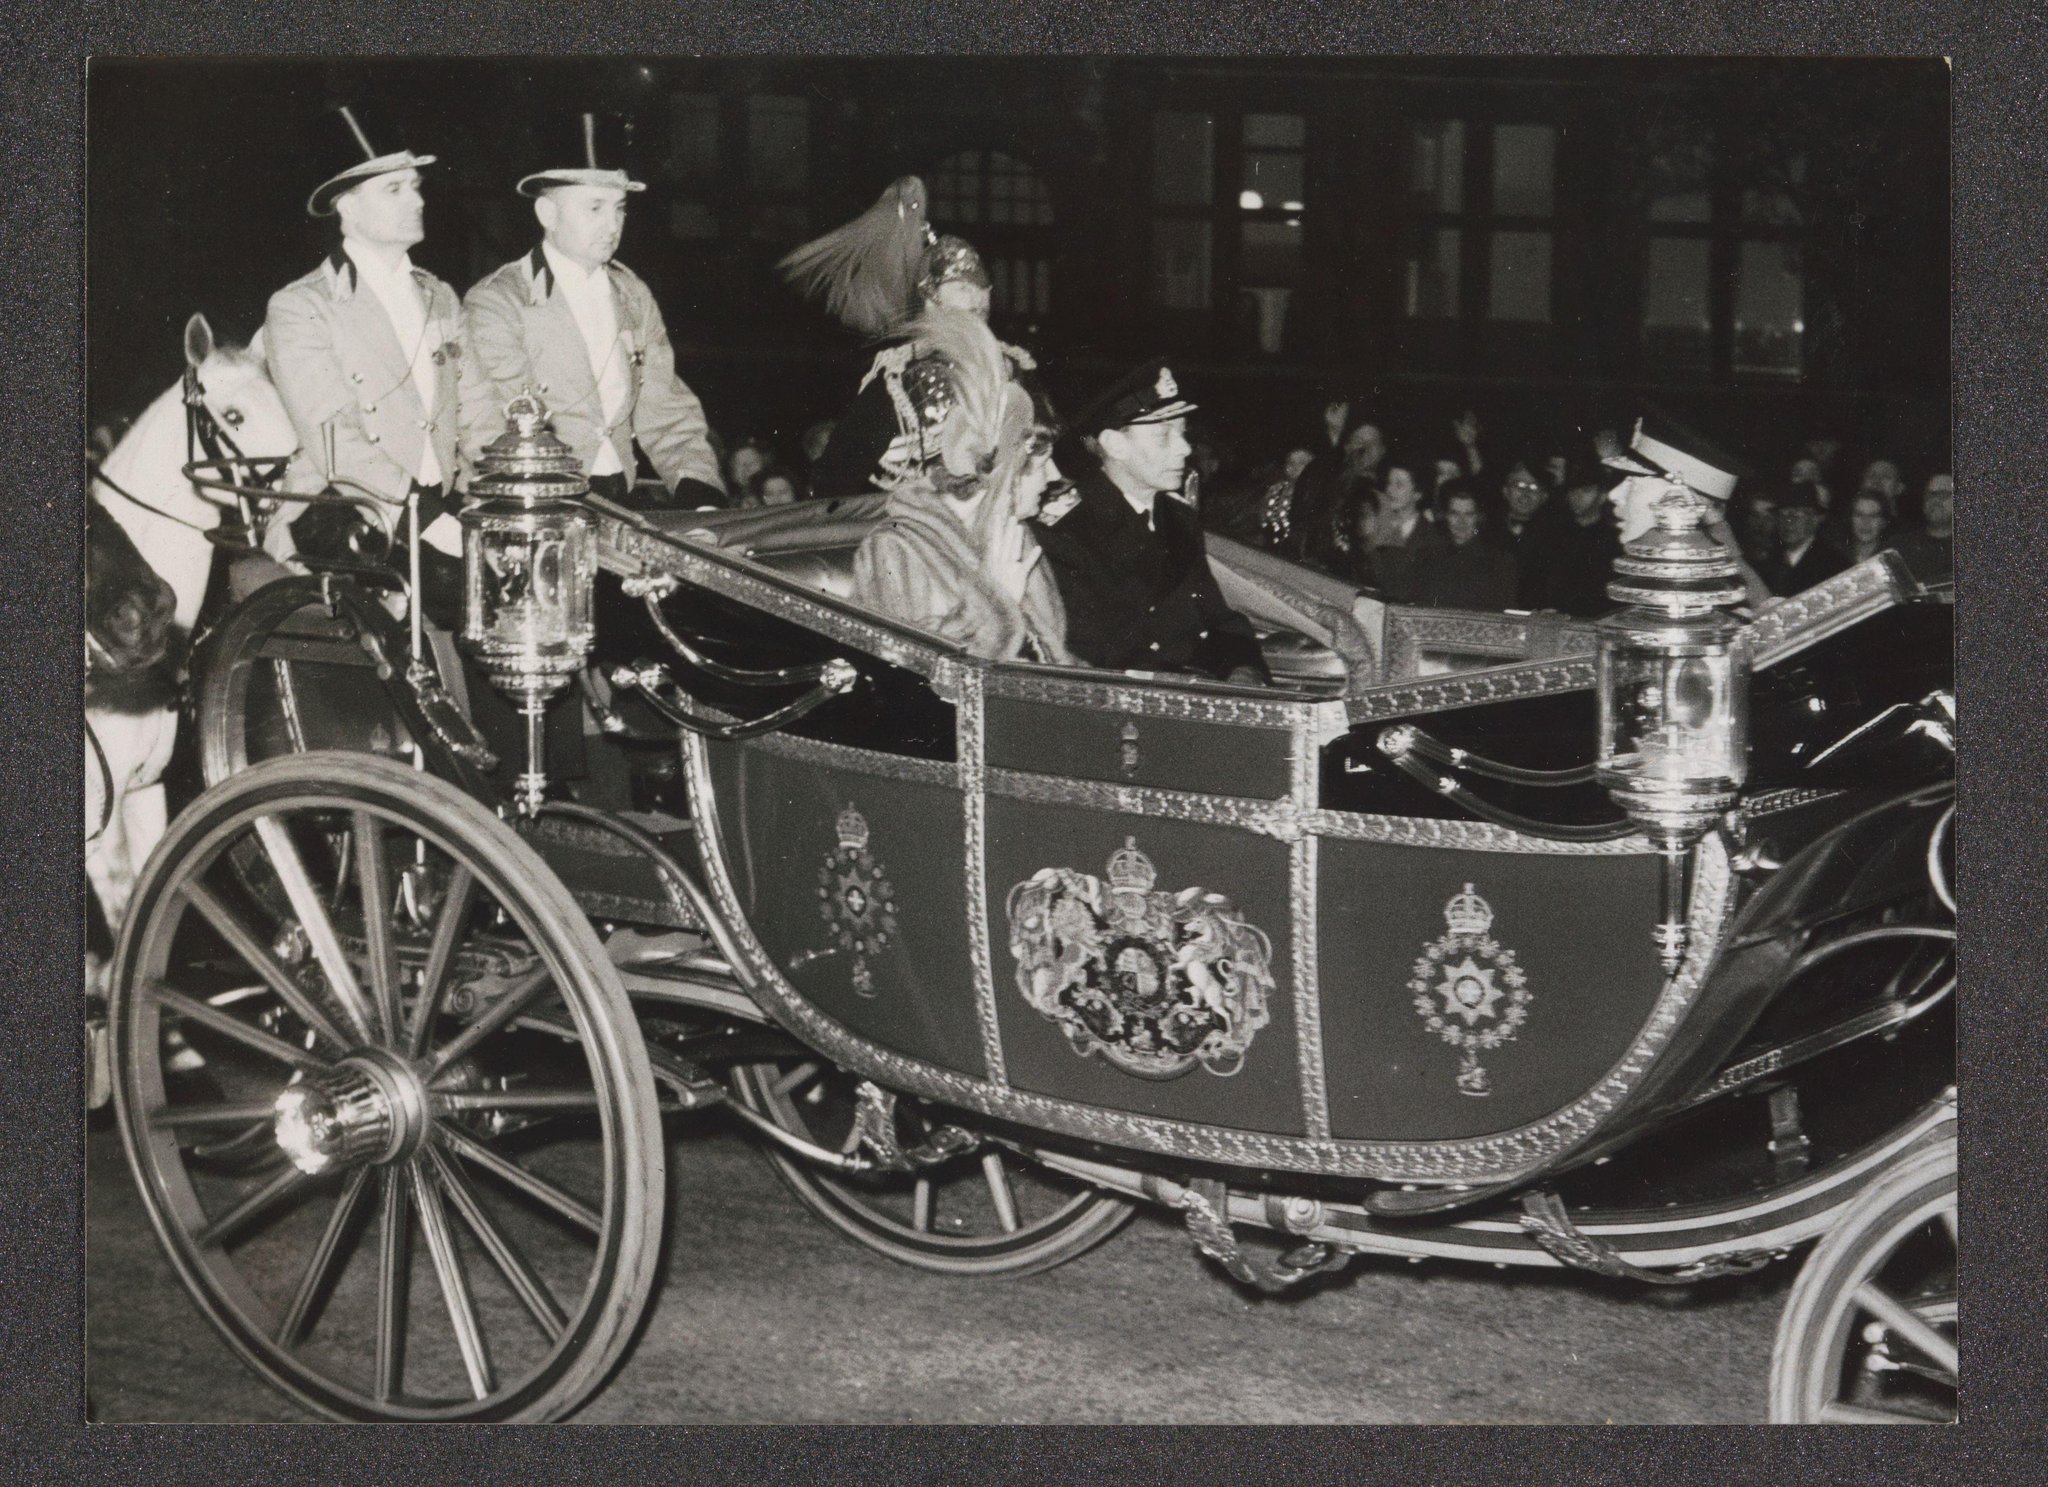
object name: photograph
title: Queen Juliana waves to the crowds as she drives with H.M The King from Victoria Station to Buckingham Palace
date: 1950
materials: paper, photographic support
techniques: gelatin silver print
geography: london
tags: juliana of the netherlands, london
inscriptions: caption: ‘State visit of Queen Juliana and Prince Bernhard’